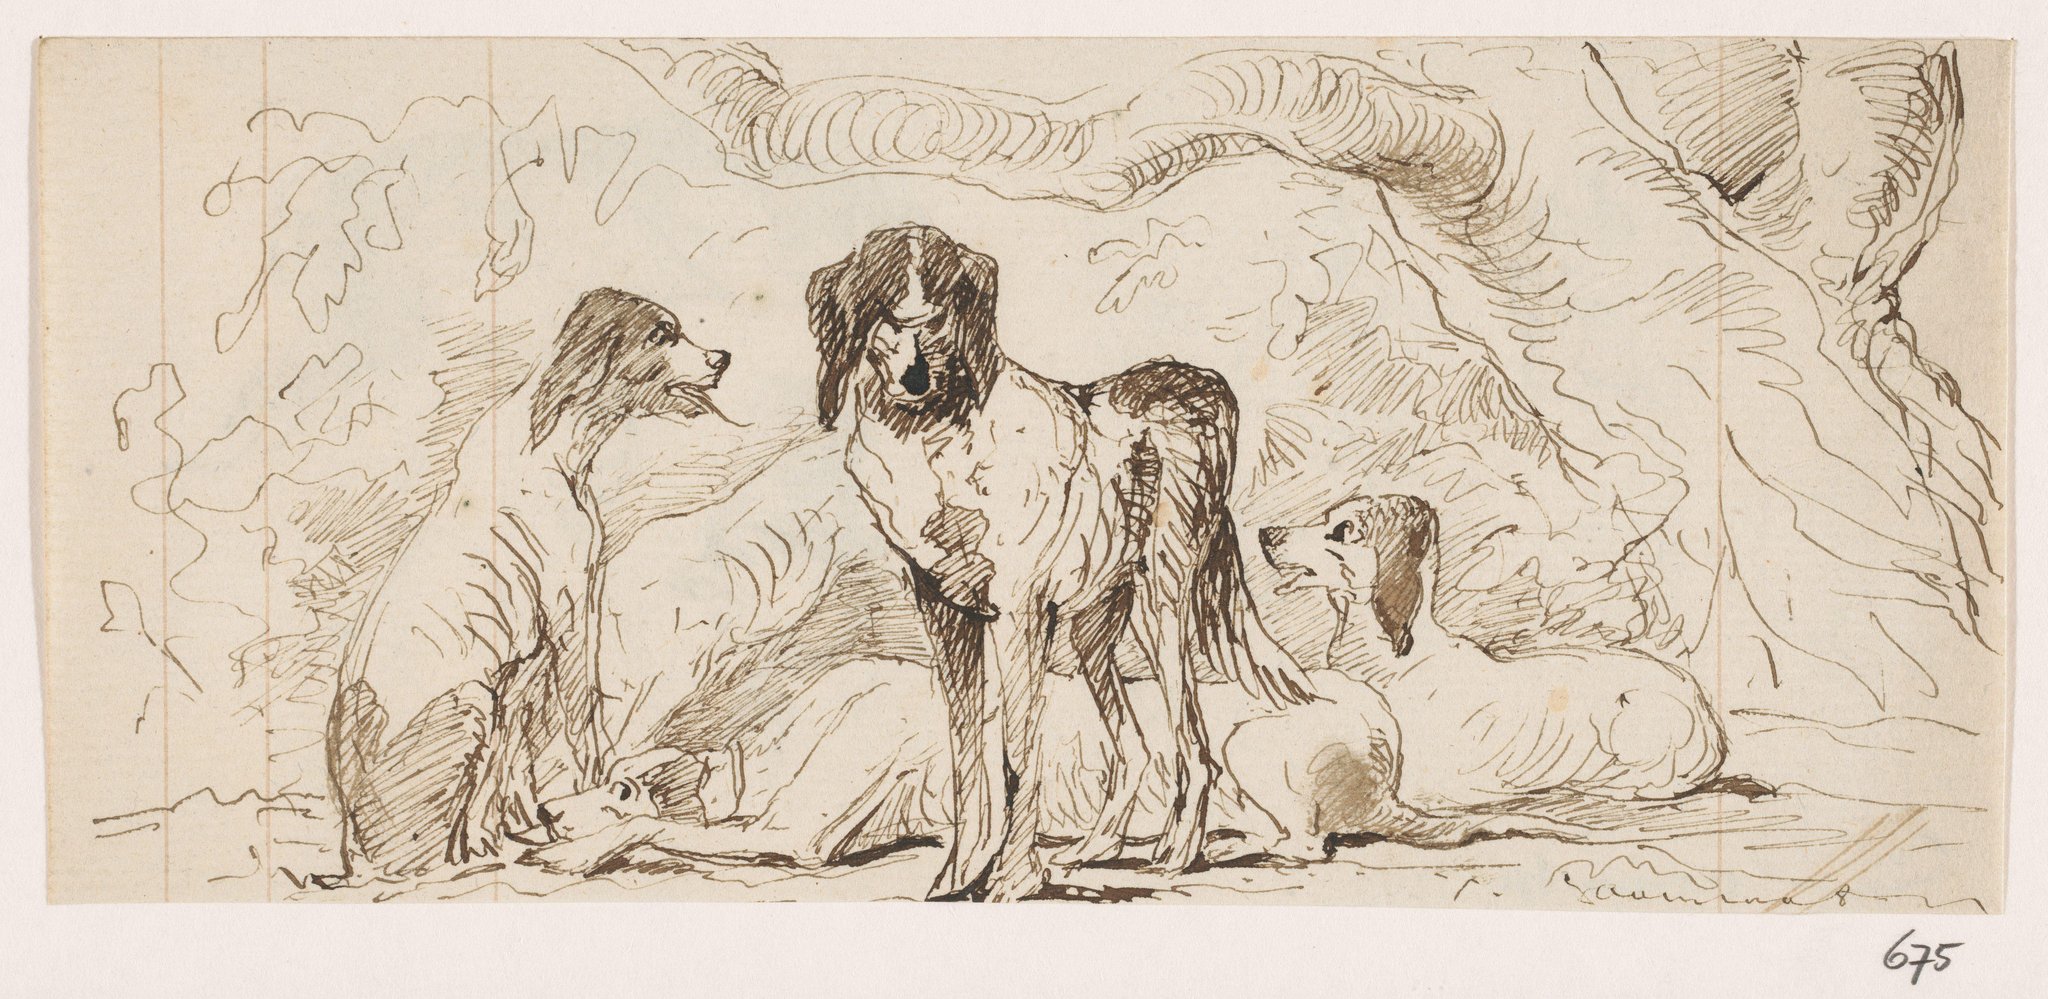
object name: drawing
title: Groep jachthonden rustend onder een boom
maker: johannes tavenraat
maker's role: draughtsman, painter, print maker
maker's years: 1809-1881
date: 1840-1880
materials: ink, paper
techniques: pen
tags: hunting dogs, hunters resting during the hunt, dog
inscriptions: signature: ‘Tavenraat’, collector's mark: Lugt 2228